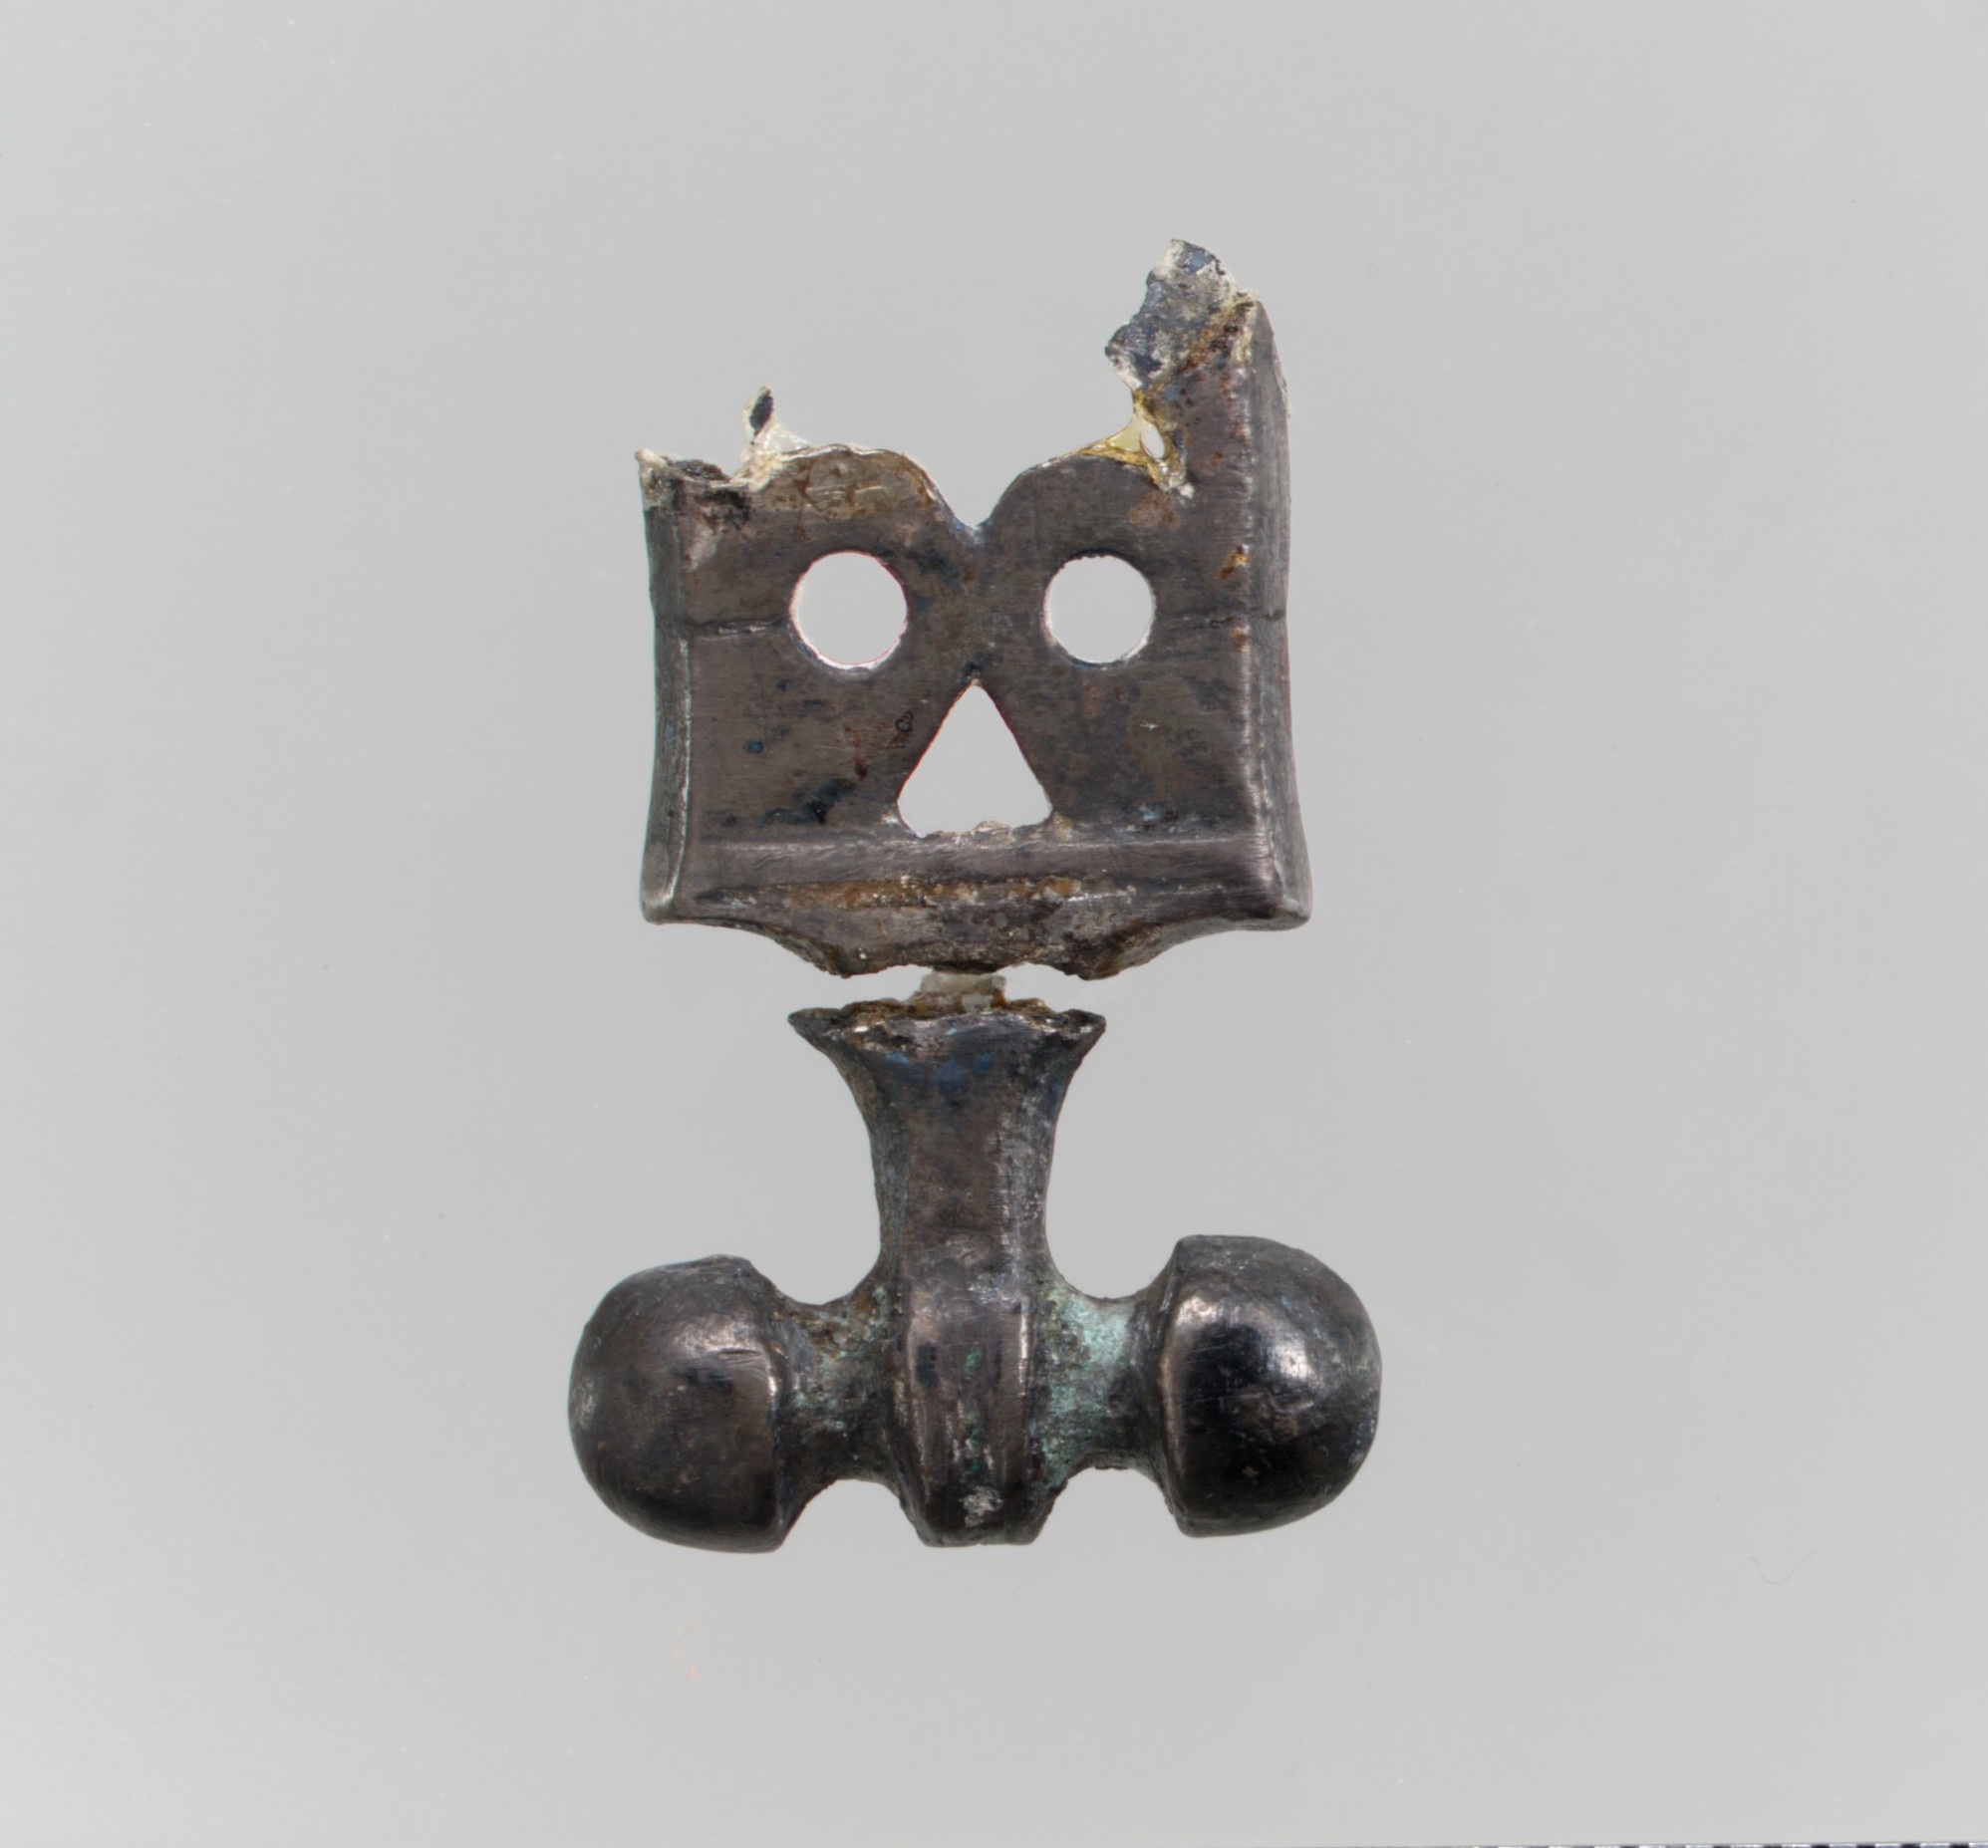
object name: belt ornament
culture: avar or byzantine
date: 575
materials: silver